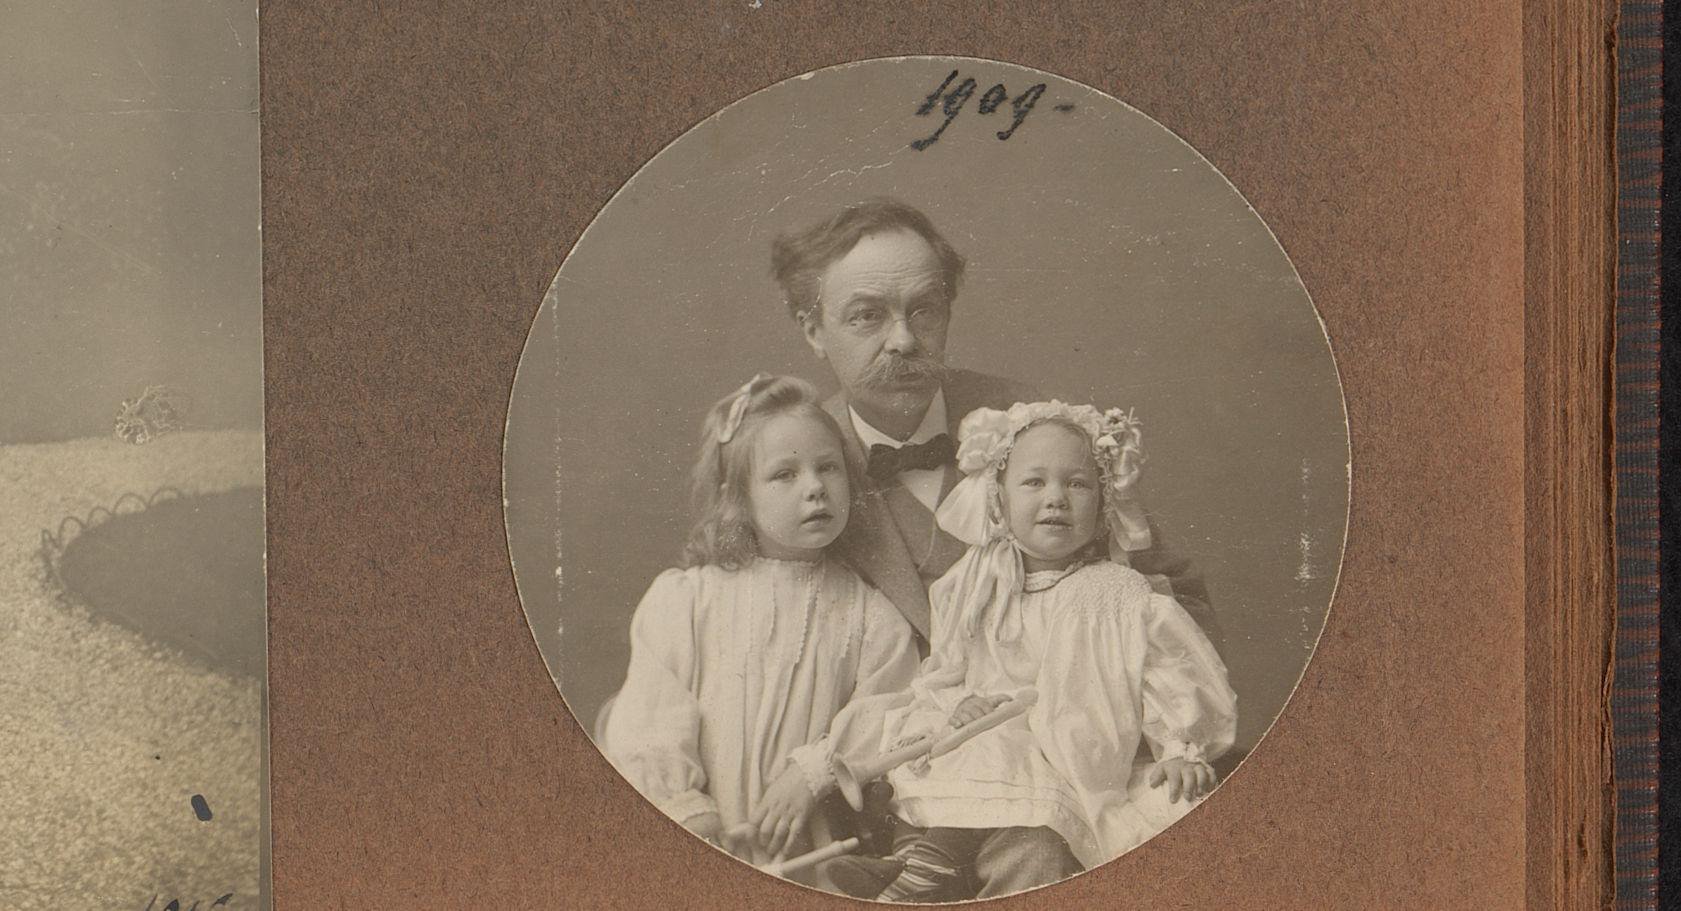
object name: photograph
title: Alphonse Diepenbrock te midden van zijn dochters Joanna en Thea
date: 1909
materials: photographic support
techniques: photography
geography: amsterdam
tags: amsterdam, alphons diepenbrock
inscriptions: date: ‘1909.’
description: Foto op bruin albumblad 27 van familiealbum van Alphons Diepenbrock.